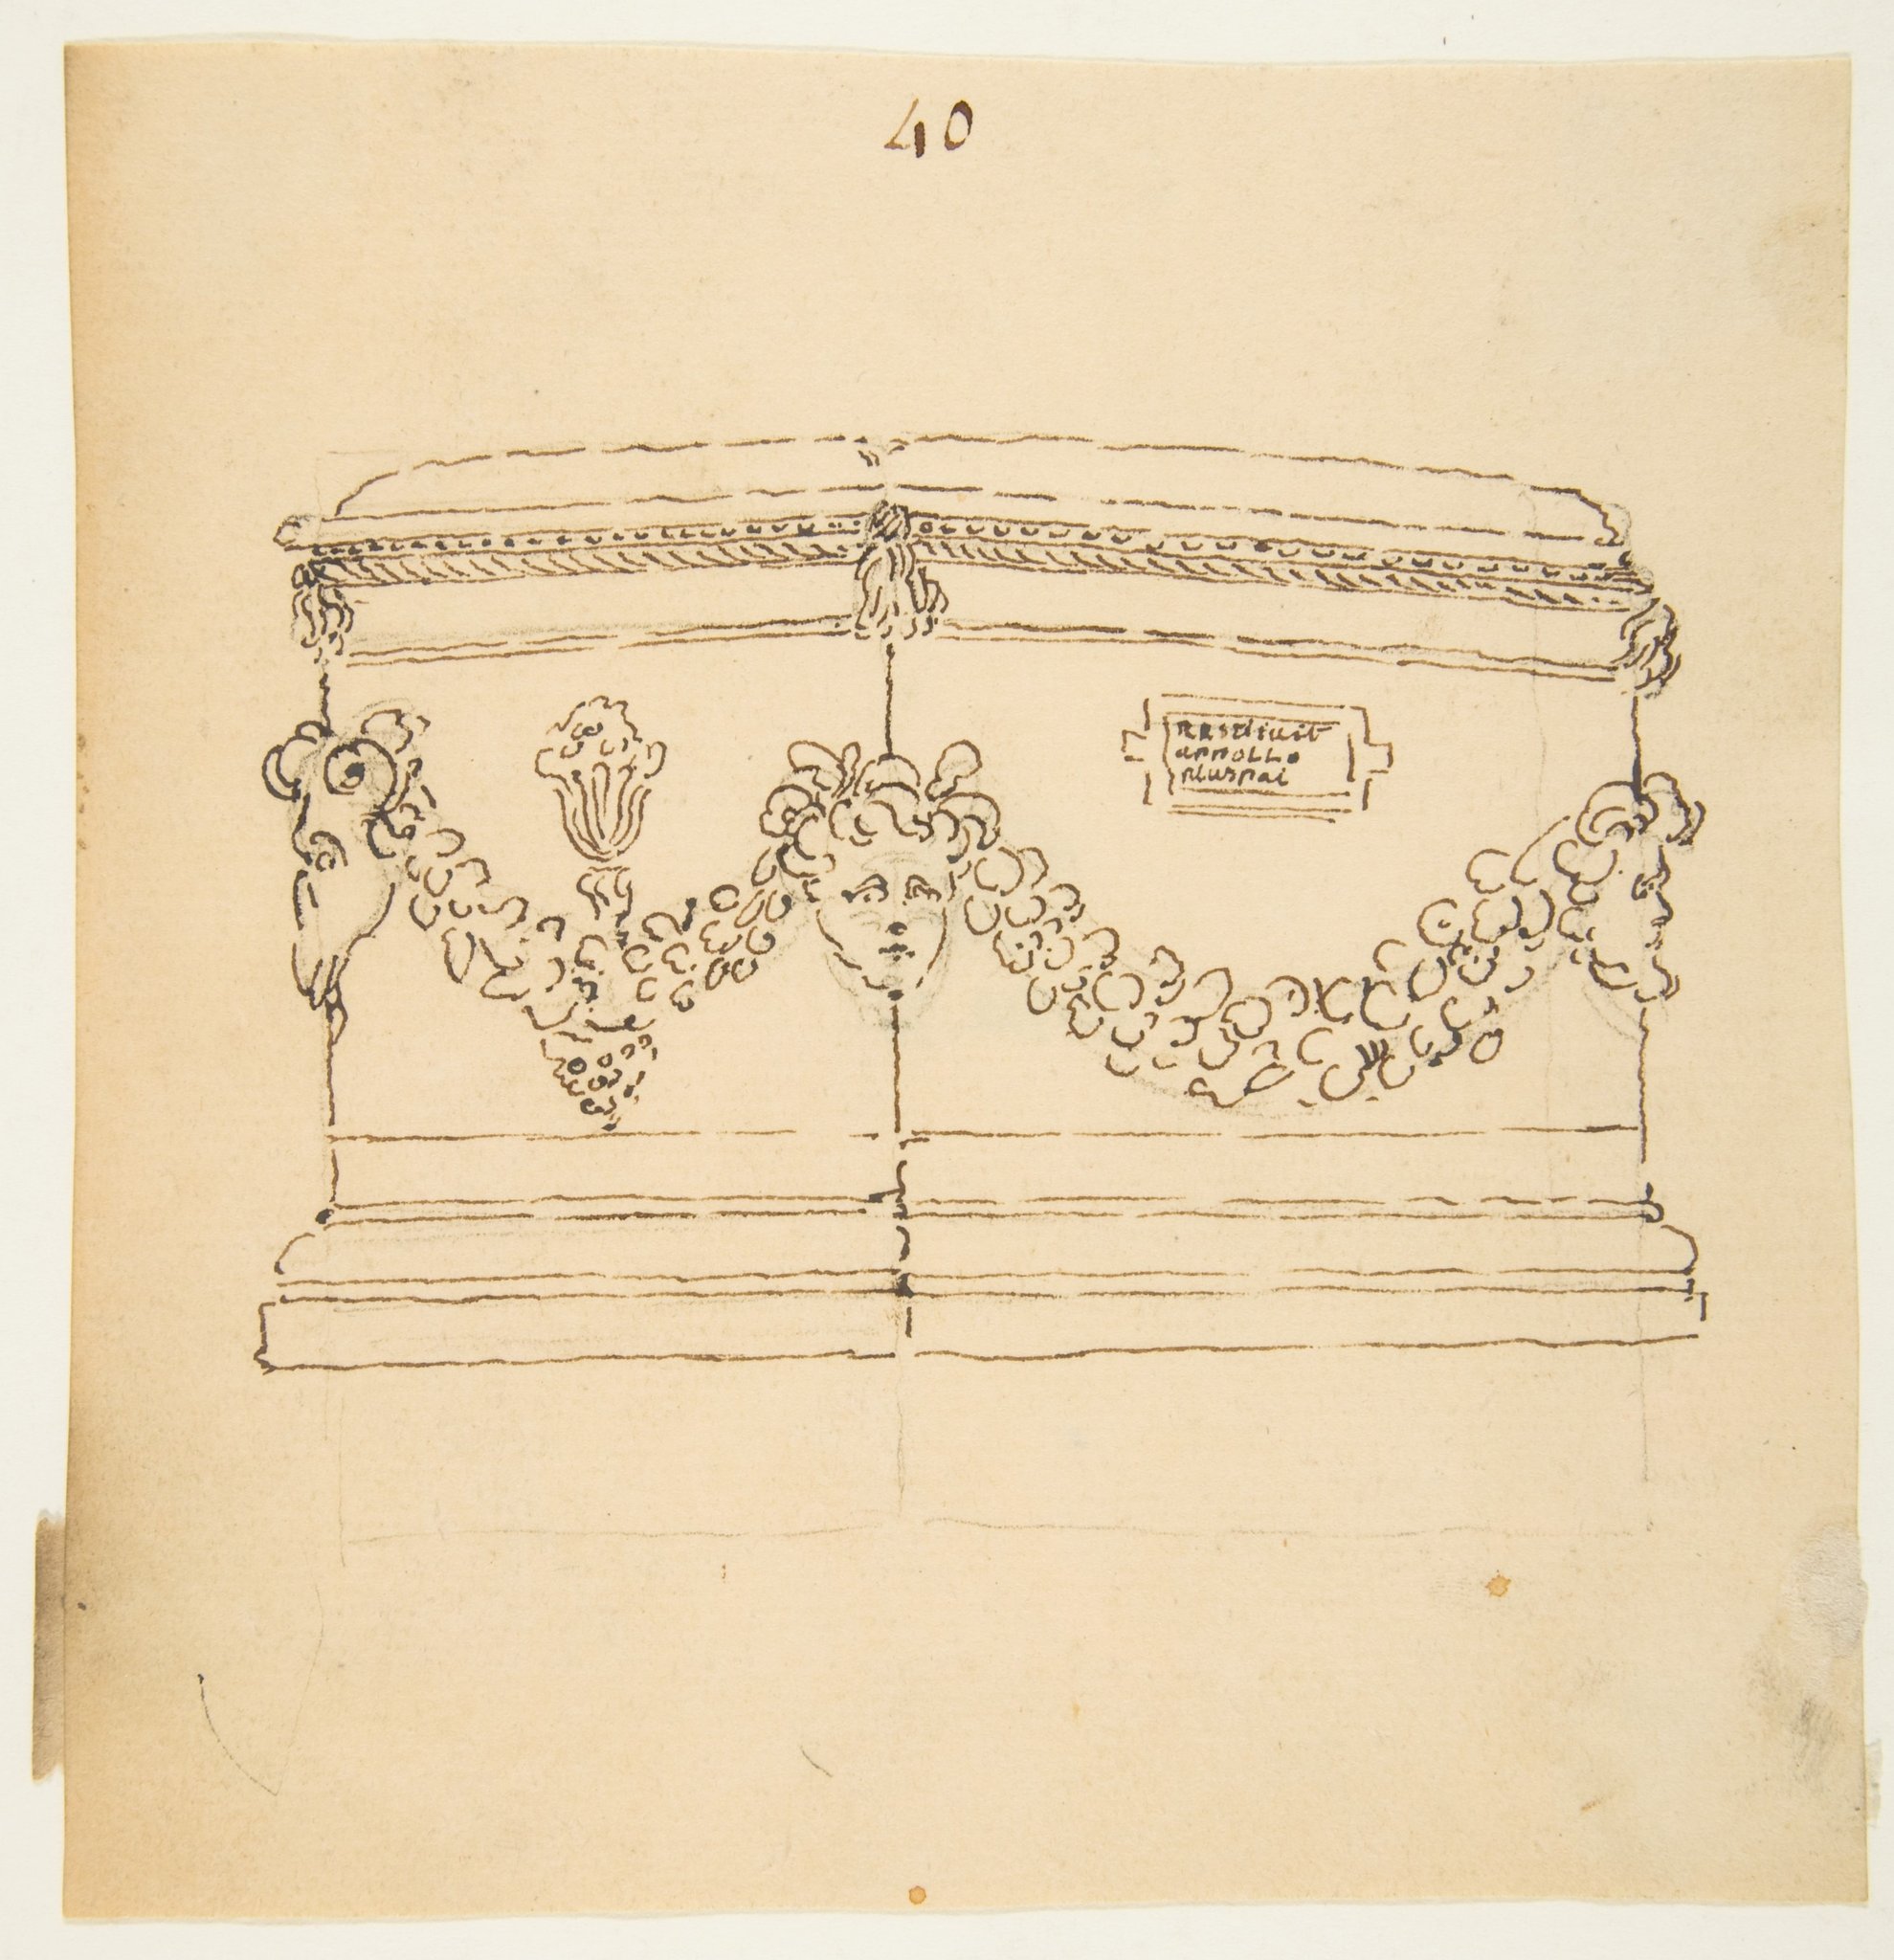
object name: drawing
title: Design for a Funerary Monument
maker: anonymous, french, 18th century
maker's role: artist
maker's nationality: french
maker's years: 1700-1800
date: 1701-1800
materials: graphite, ink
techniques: pen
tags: monuments